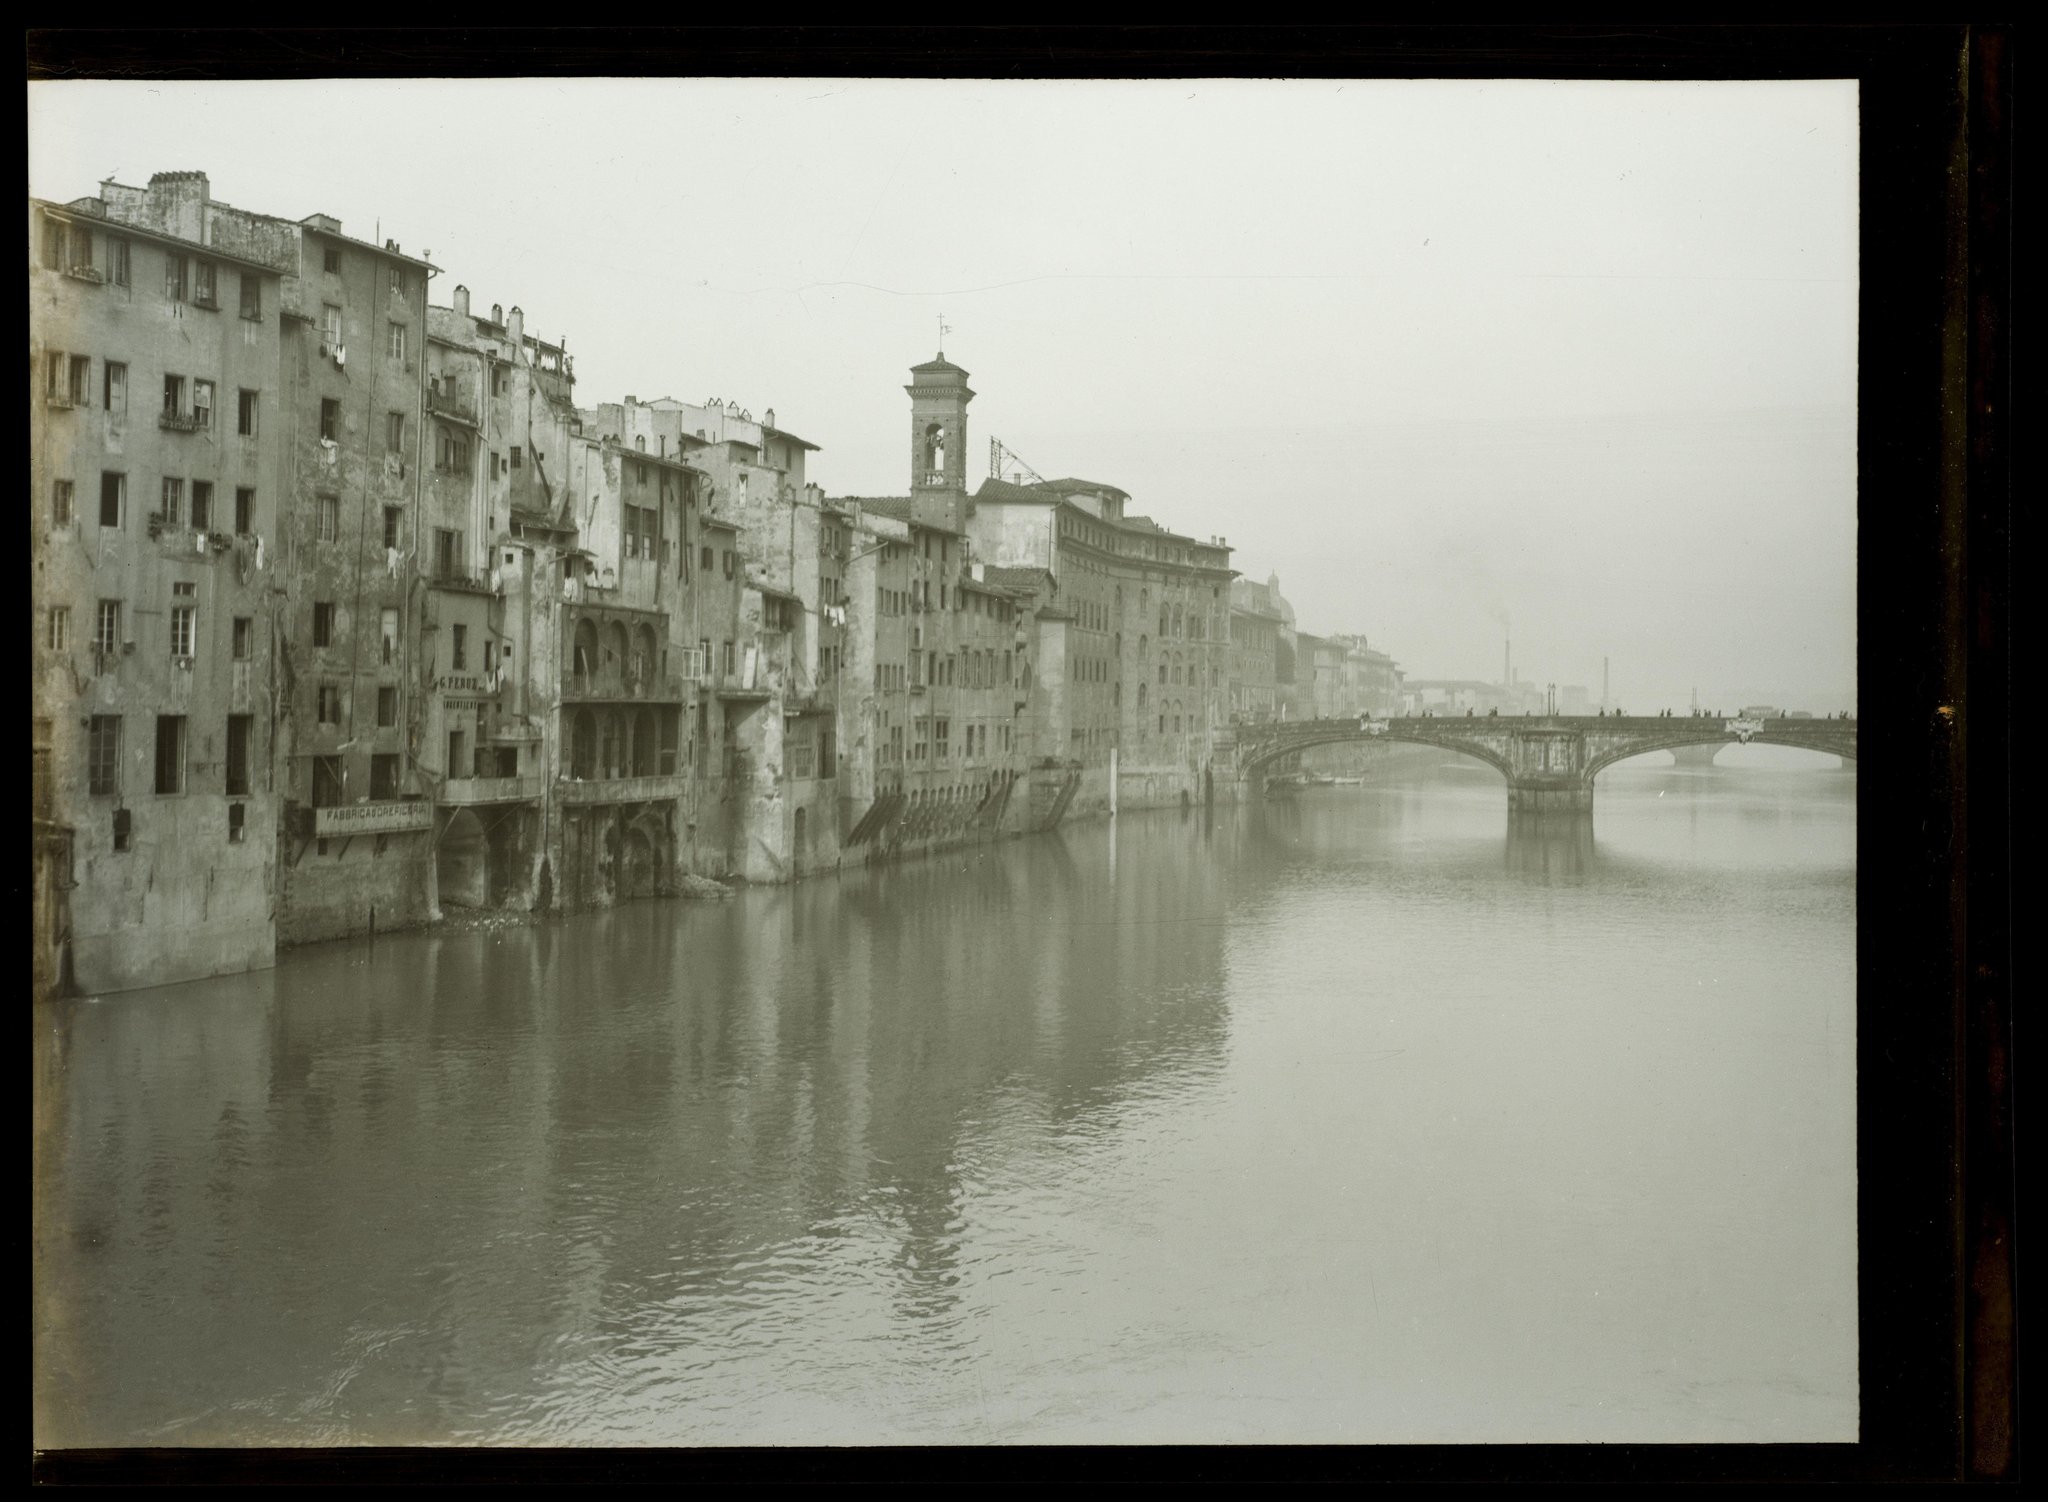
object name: photograph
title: Filmnegatief met opname van Florence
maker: Anonymous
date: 1907-1935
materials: film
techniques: gelatin silver negative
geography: florence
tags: florence